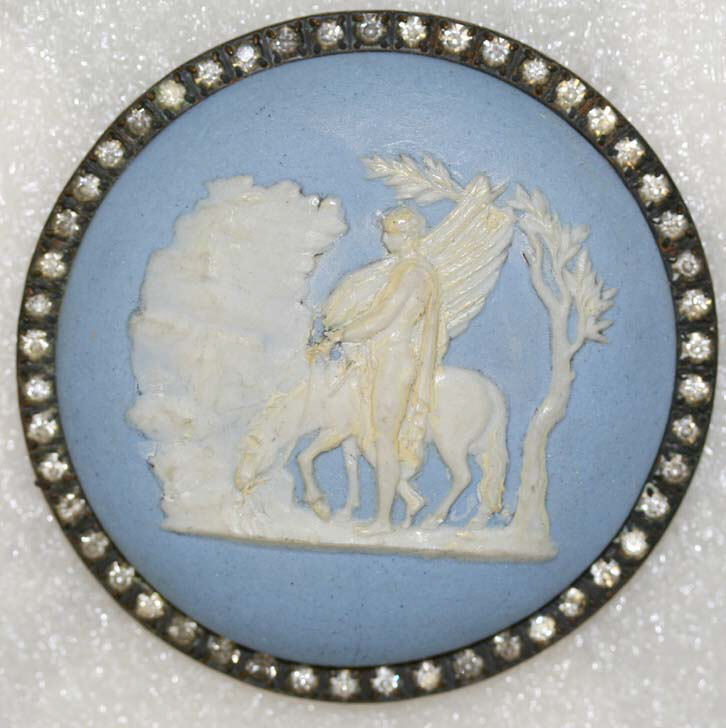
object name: button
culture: european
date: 1701-1800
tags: cameos,men,horses